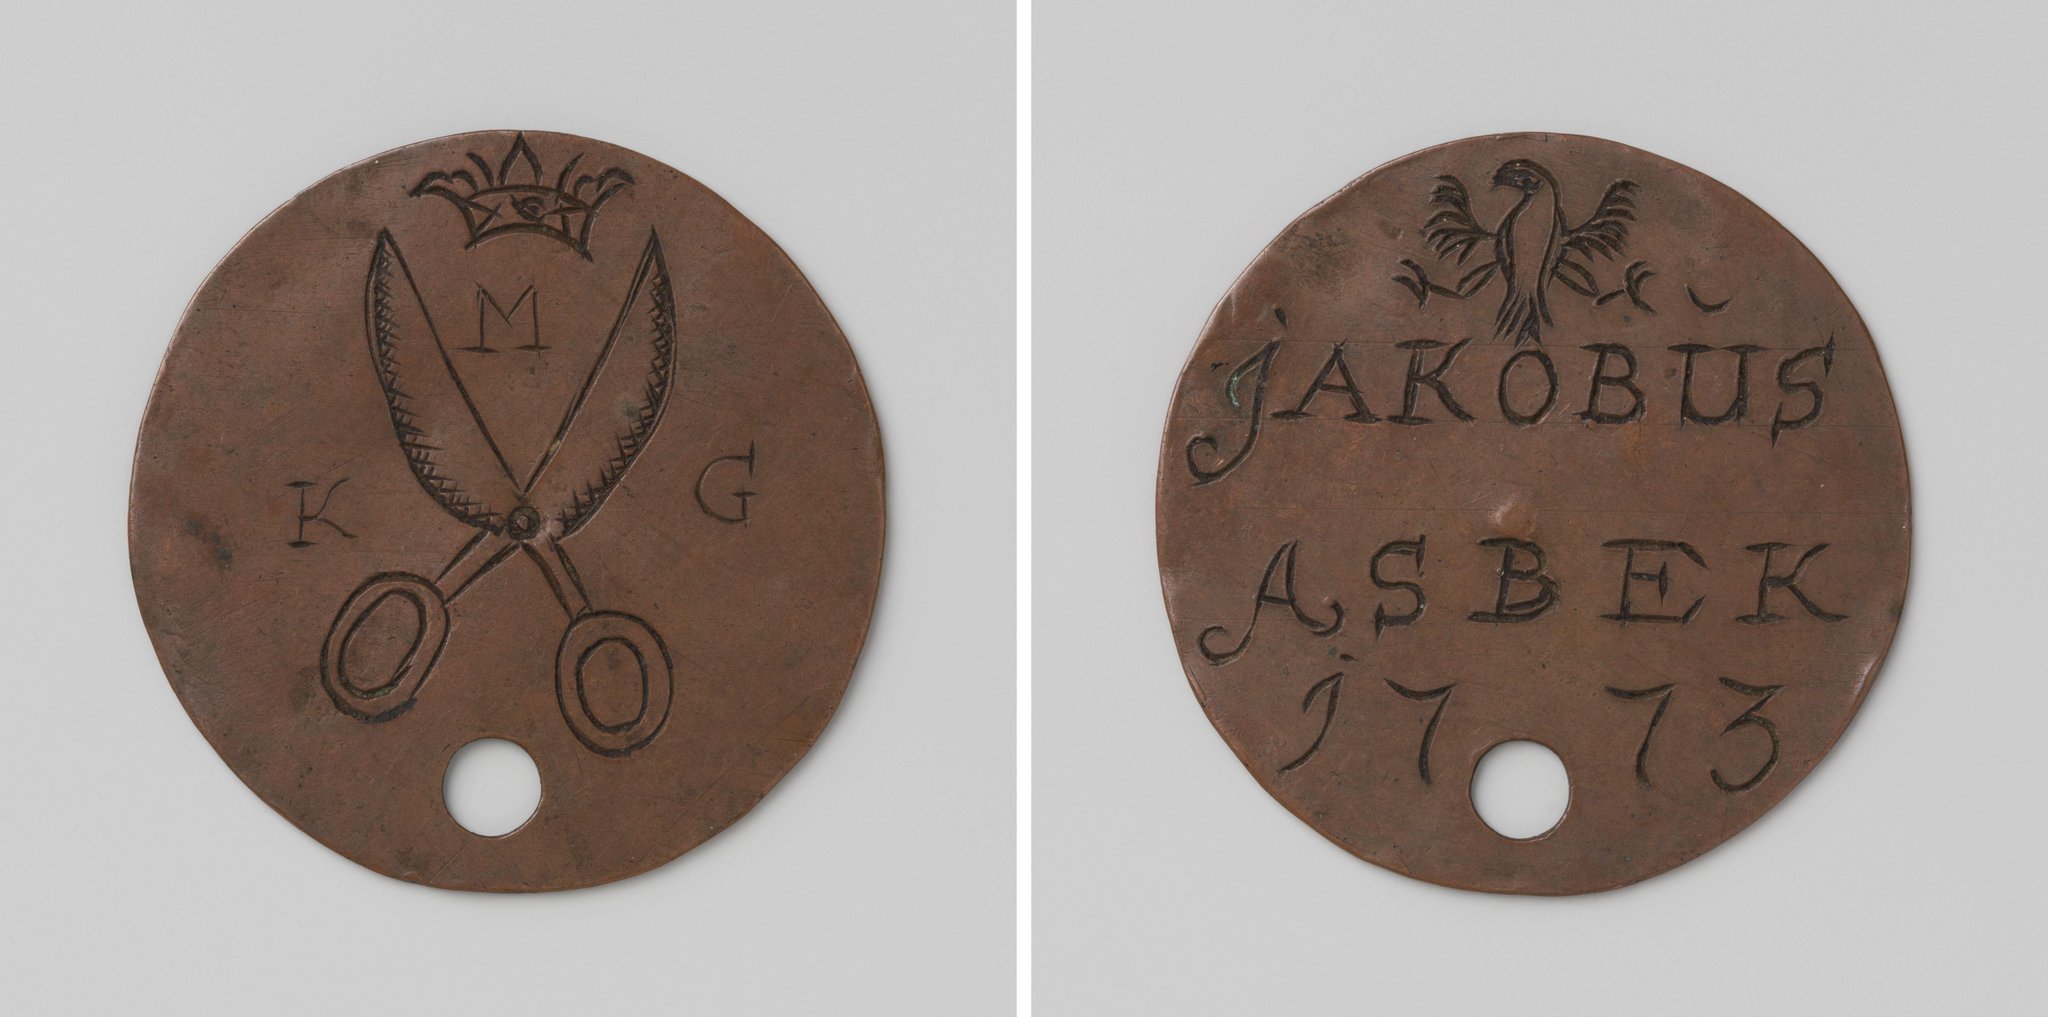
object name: medal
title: Gildepenning van het Kleermakersgilde van Deventer, op naam van Jakobus Asbek.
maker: Anonymous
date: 1773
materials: copper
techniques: engraving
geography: deventer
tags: deventer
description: Koperen penning met gat erin. Voorzijde: geopende schaar, omgeven door de letters K, M en G onder een kroon. Keerzijde: adelaar boven opschrift